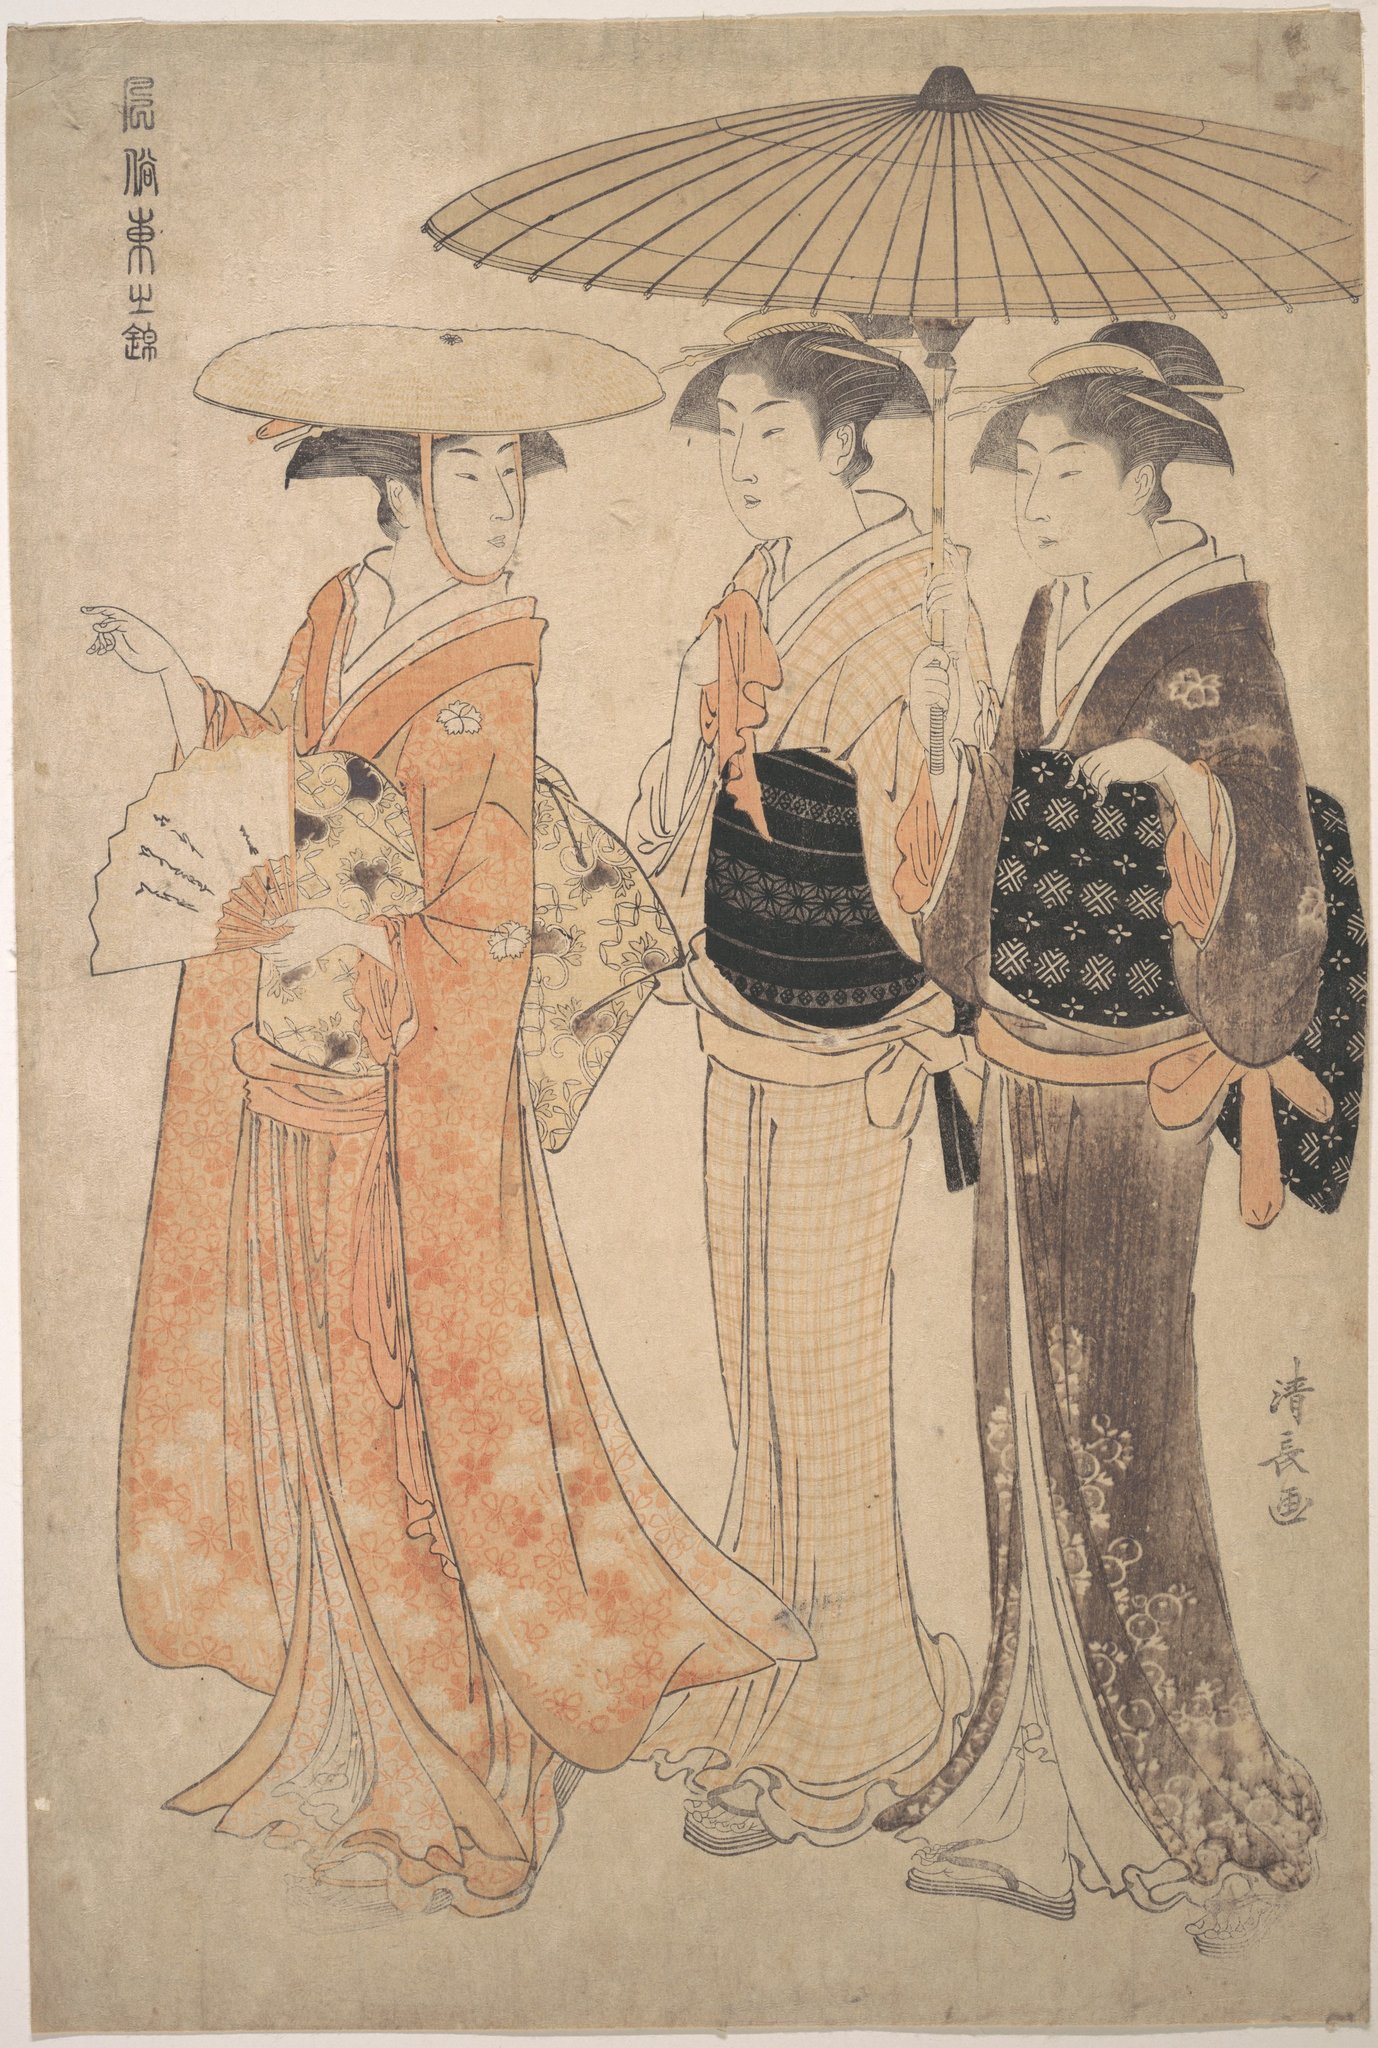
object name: print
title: The Promenade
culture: japanese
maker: torii kiyonaga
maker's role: artist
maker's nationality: japanese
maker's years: 1752-1815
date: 1742-1815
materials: ink, paper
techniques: woodblock print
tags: women,walking